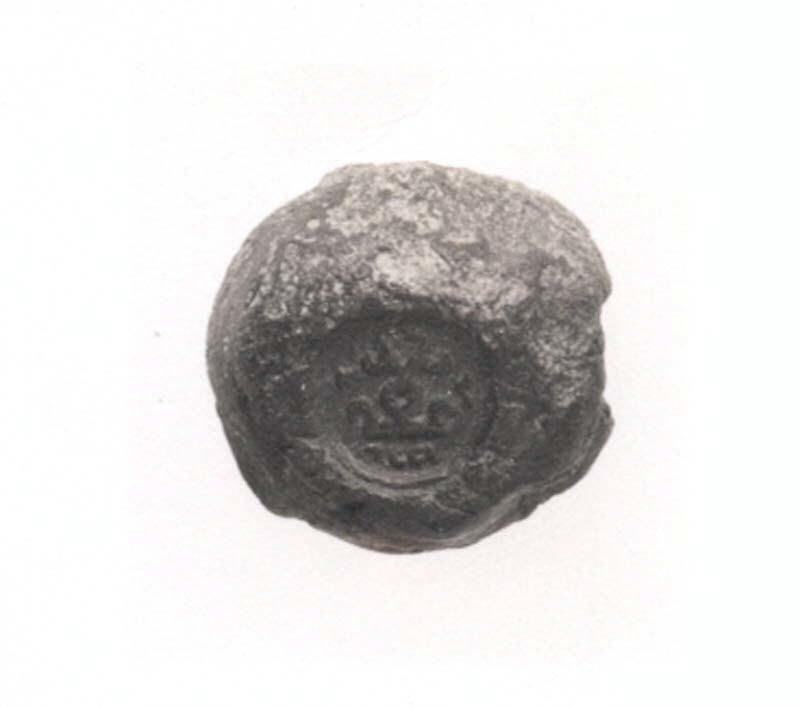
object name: sealing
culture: sasanian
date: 601-700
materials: clay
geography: iran